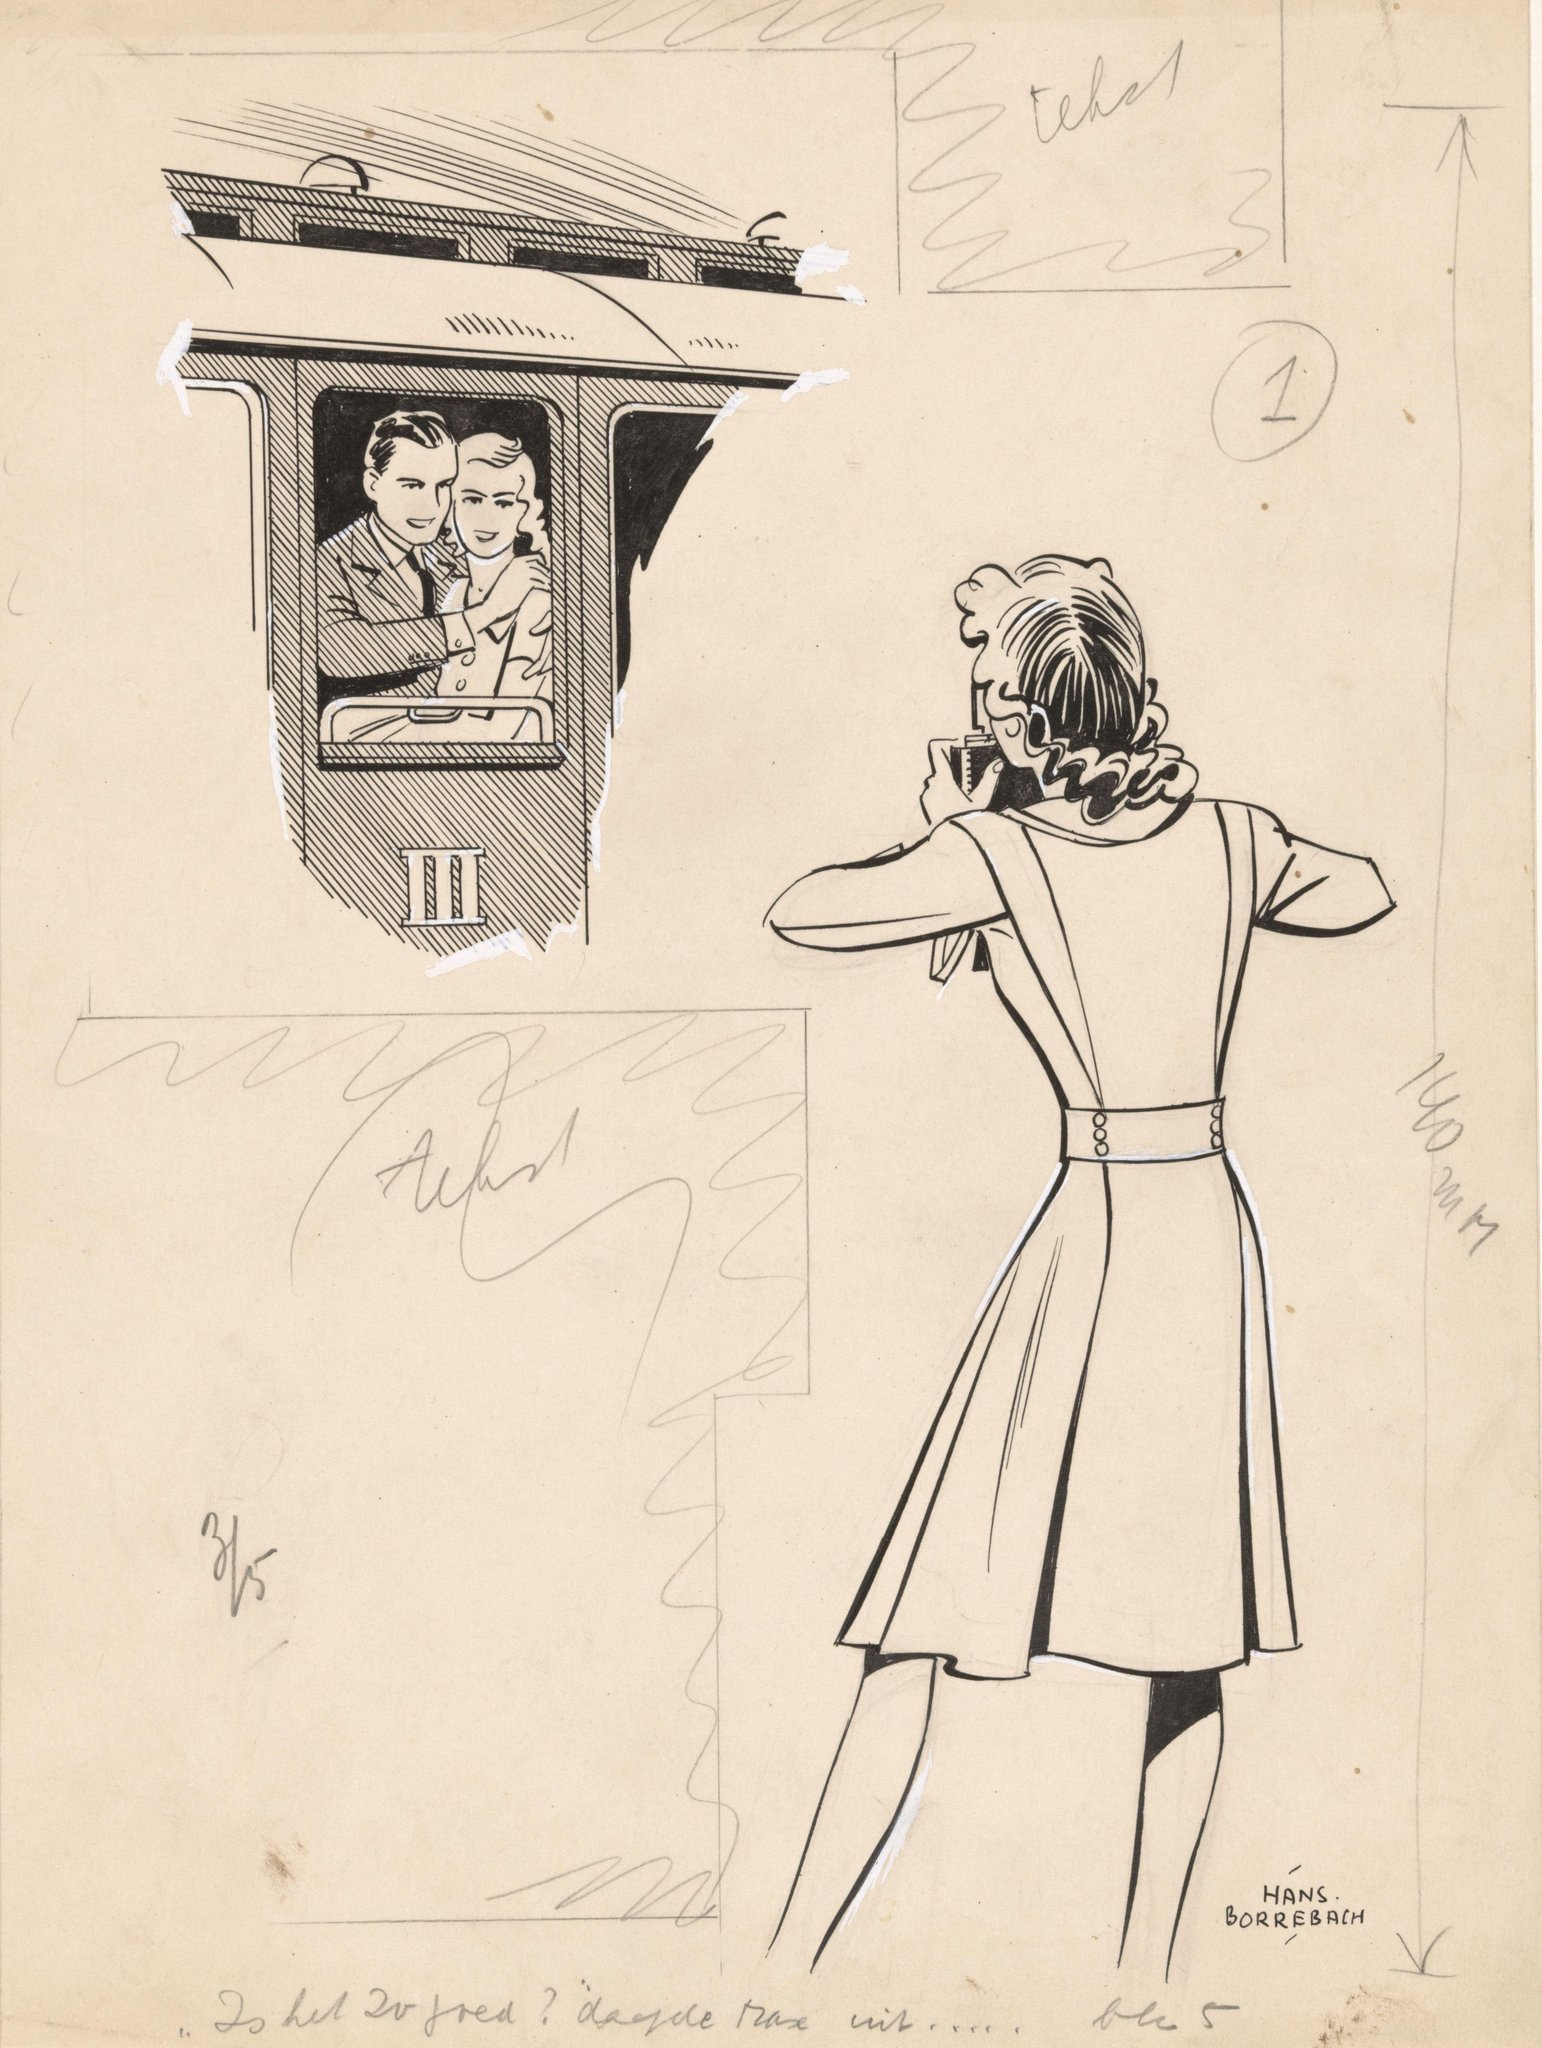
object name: boekillustratie ontwerp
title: Pepita fotografeert een stel in een trein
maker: hans borrebach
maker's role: draughtsman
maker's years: 1903-1991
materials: paint, ink, paper, pencil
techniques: brush, pen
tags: passenger train, taking photographs, couple of lovers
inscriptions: :, annotation: ‘tekst/ tekst/ "Is het zo goed?" daagde [...] uit ..... blz 5’, signature: ‘HANS./ BORREBACH’, collector's mark: Lugt 2228a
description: Een omhelzende man en vrouw zitten voor het raam van een treincoupé. Ze glimlachen naar Pepita die hen van buitenaf fotografeert.